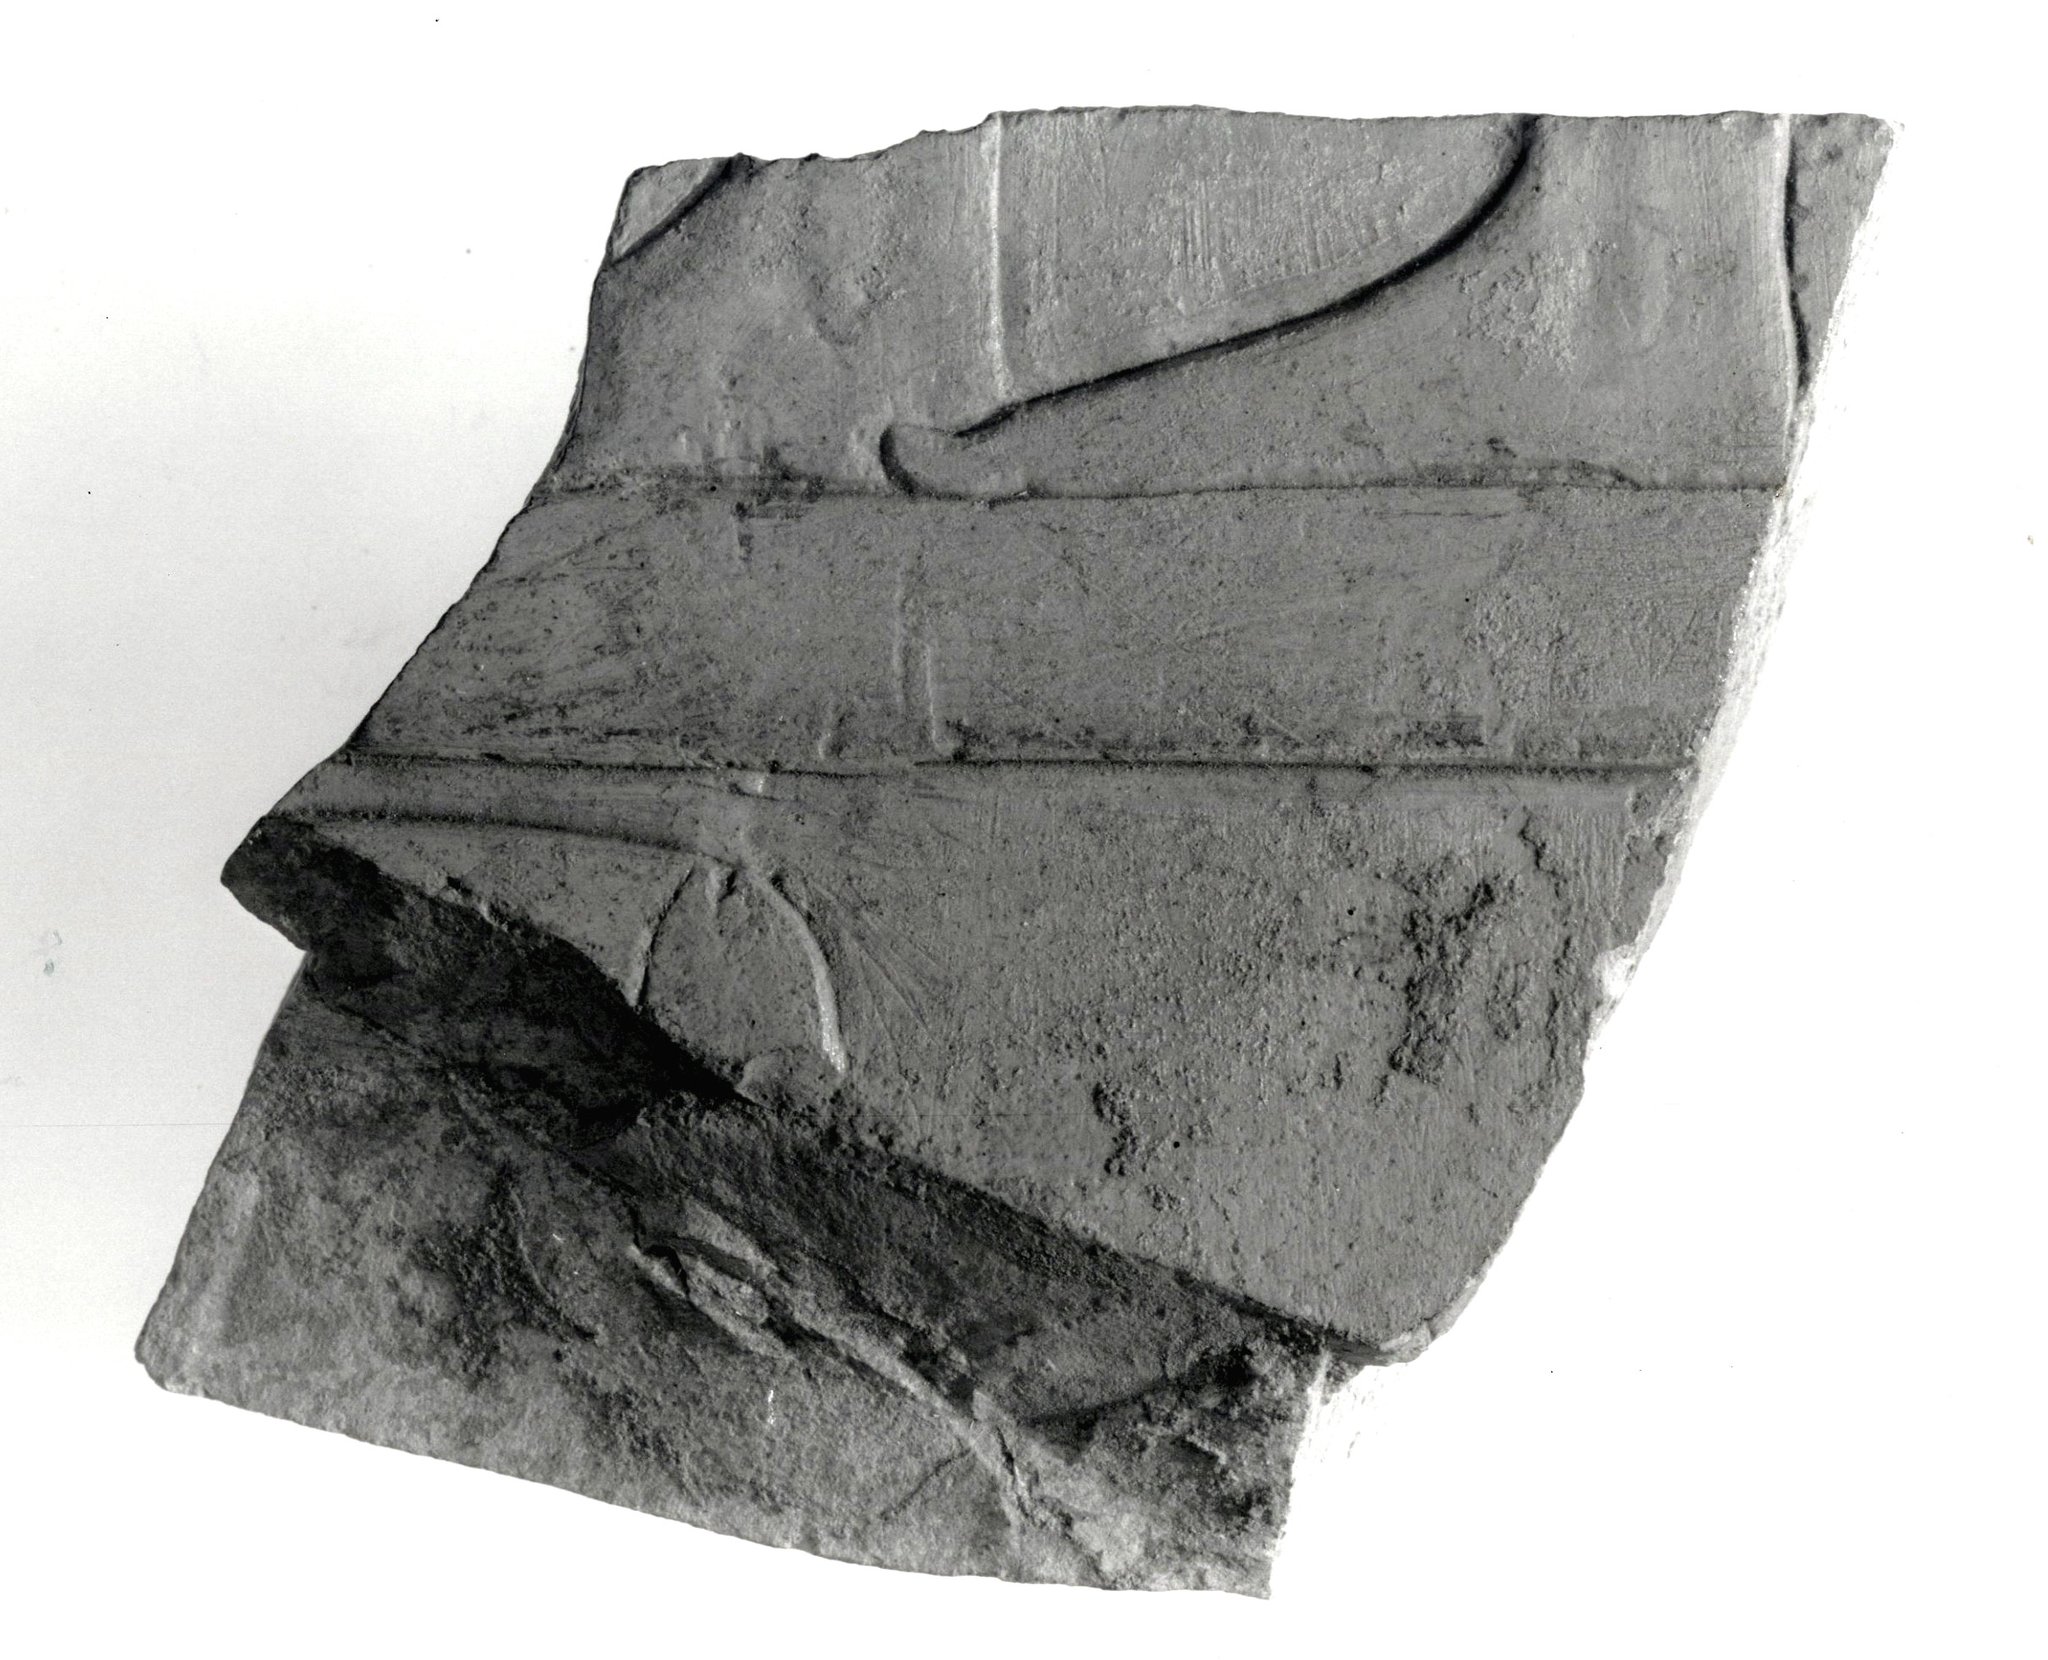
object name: relief, tomb of nespekashuty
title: Raised relief fragment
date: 664-610 BCE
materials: limestone, varnish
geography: egypt